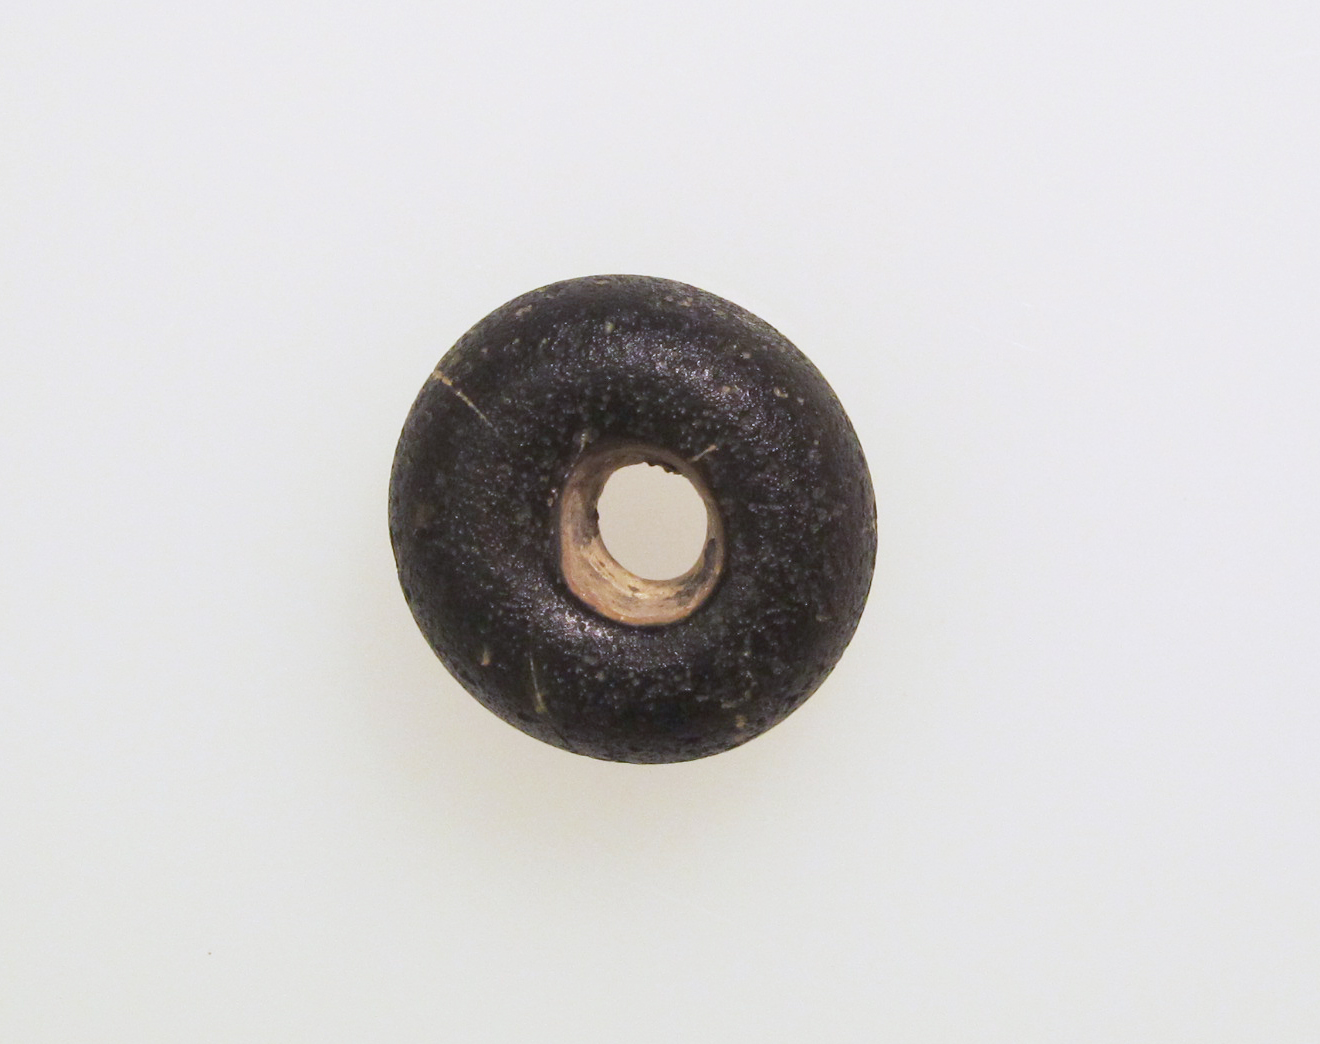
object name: bead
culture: roman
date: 670 BCE-330 CE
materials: glass